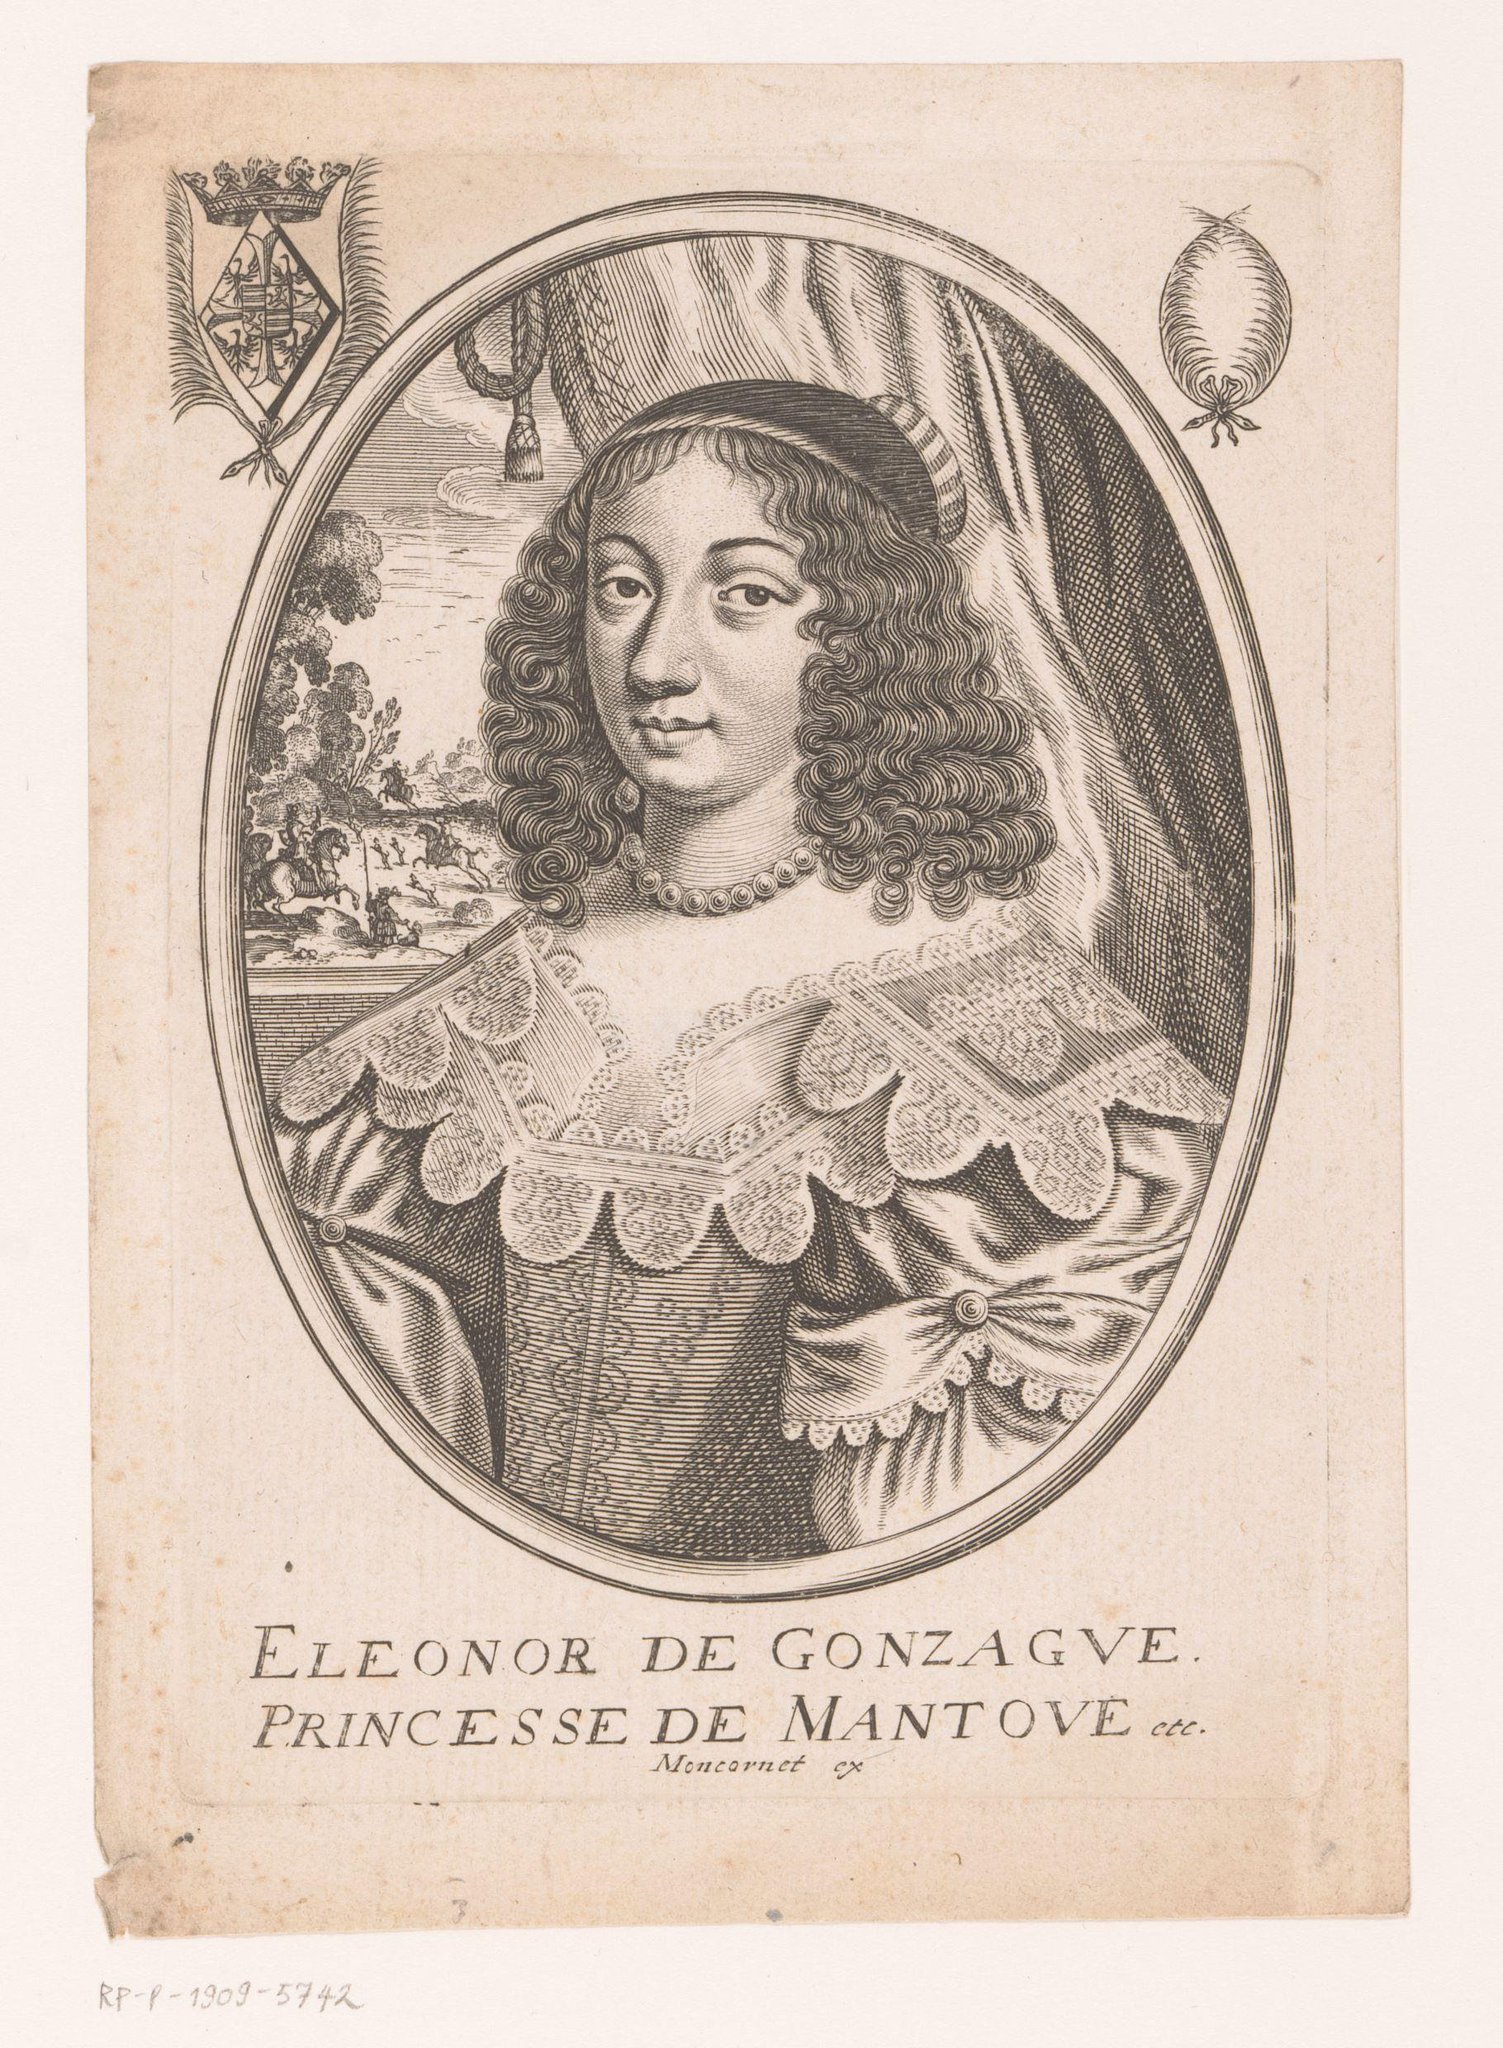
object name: print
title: Portret van Eleonora Gonzaga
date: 1617-1668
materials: paper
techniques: engraving, etching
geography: paris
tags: vienna, historical persons - bb - woman, princess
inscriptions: collector's mark: Lugt 2228